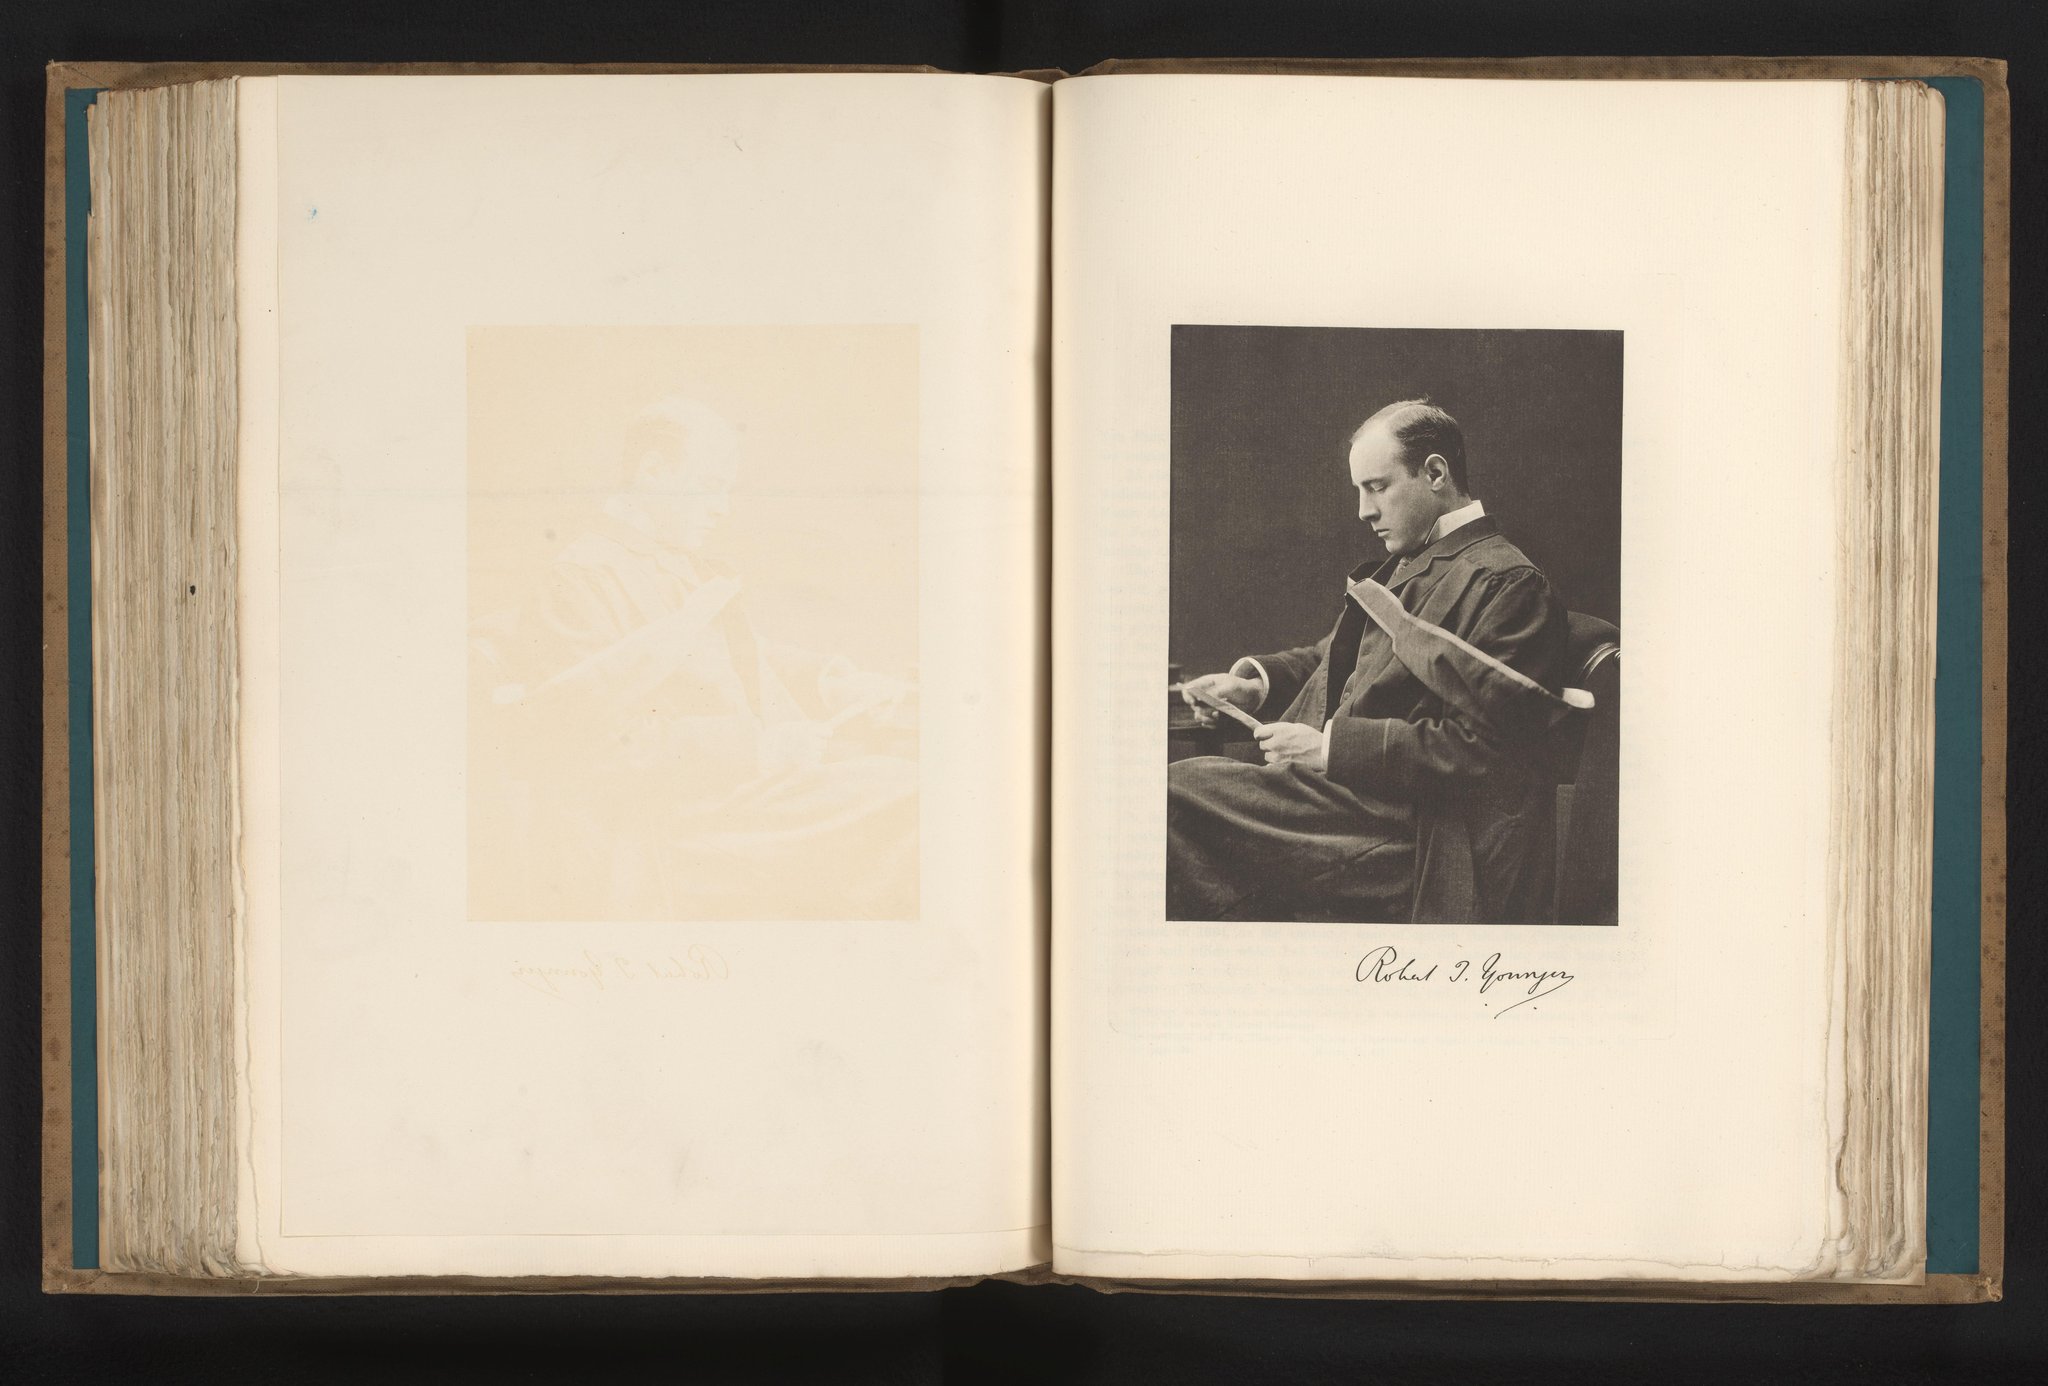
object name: page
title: Robert T. Younger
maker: Anonymous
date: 1886-1891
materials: paper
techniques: photoaquatint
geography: glasgow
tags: historical persons, lawyer, attorney at law, professor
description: Prent op negende ongenummerde pagina na pagina 100.